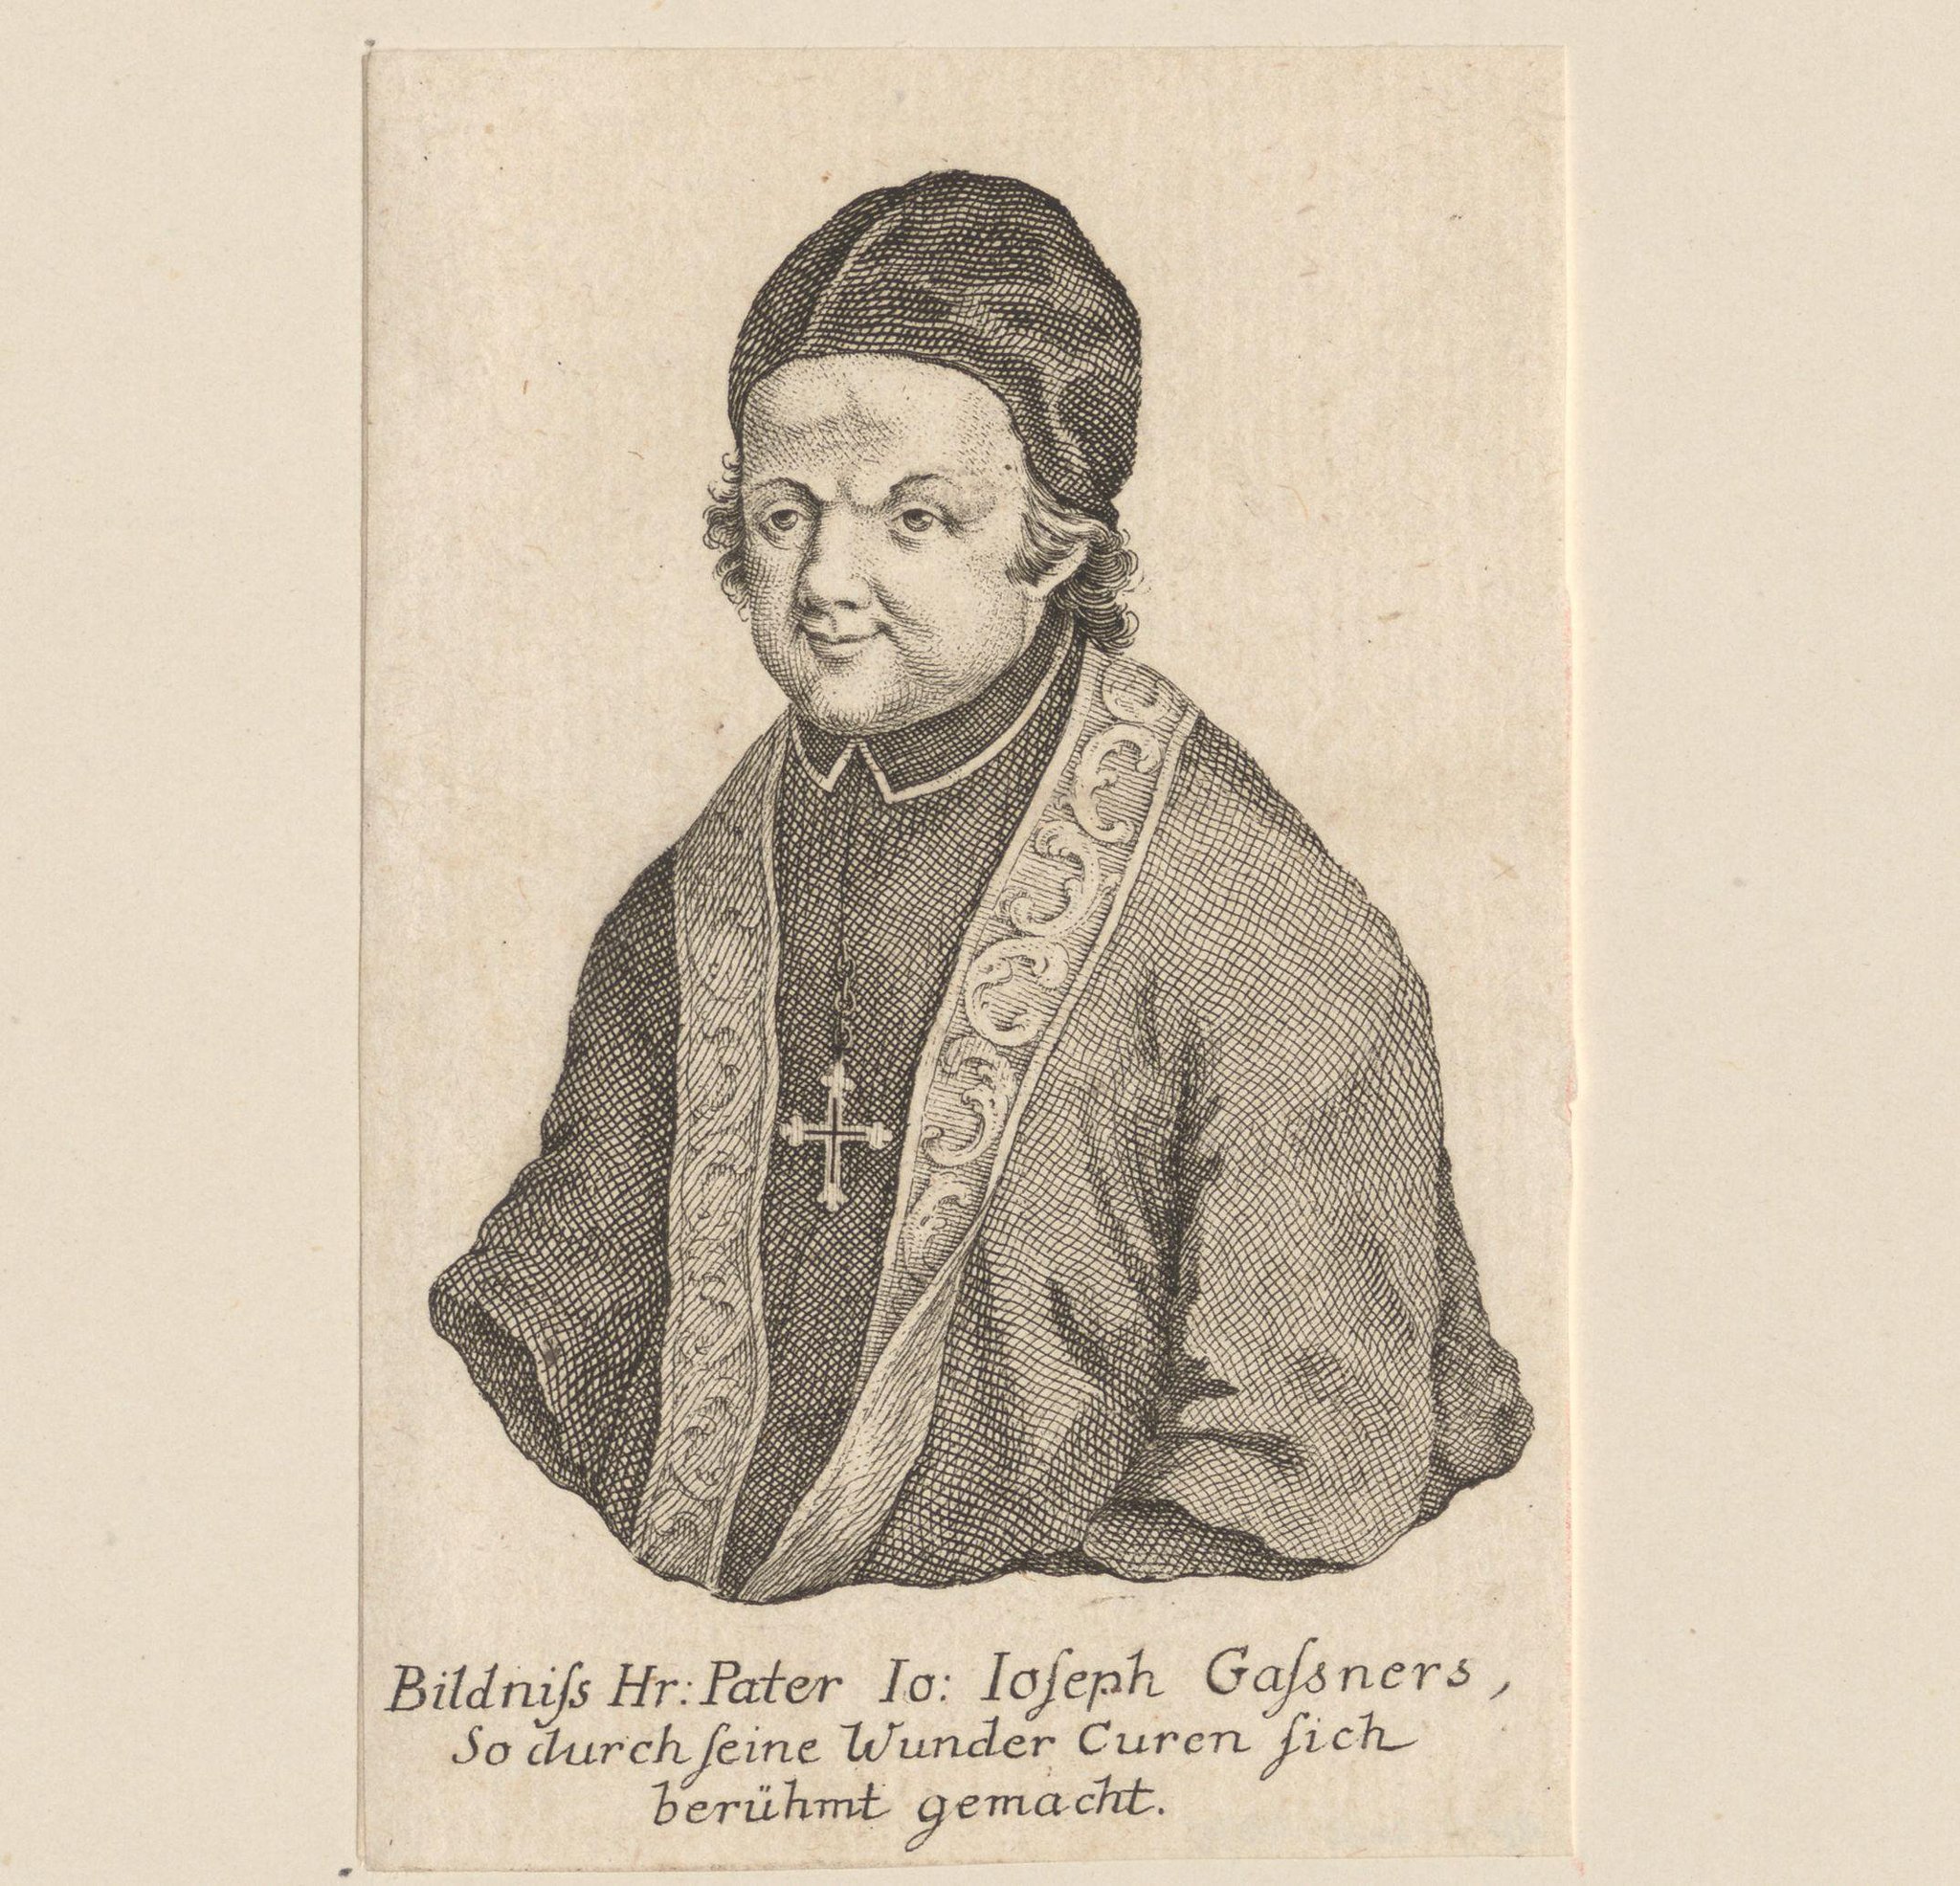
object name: print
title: Portret van Johann Joseph Gassner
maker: Anonymous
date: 1750-1779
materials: paper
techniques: engraving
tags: theologian, historical persons